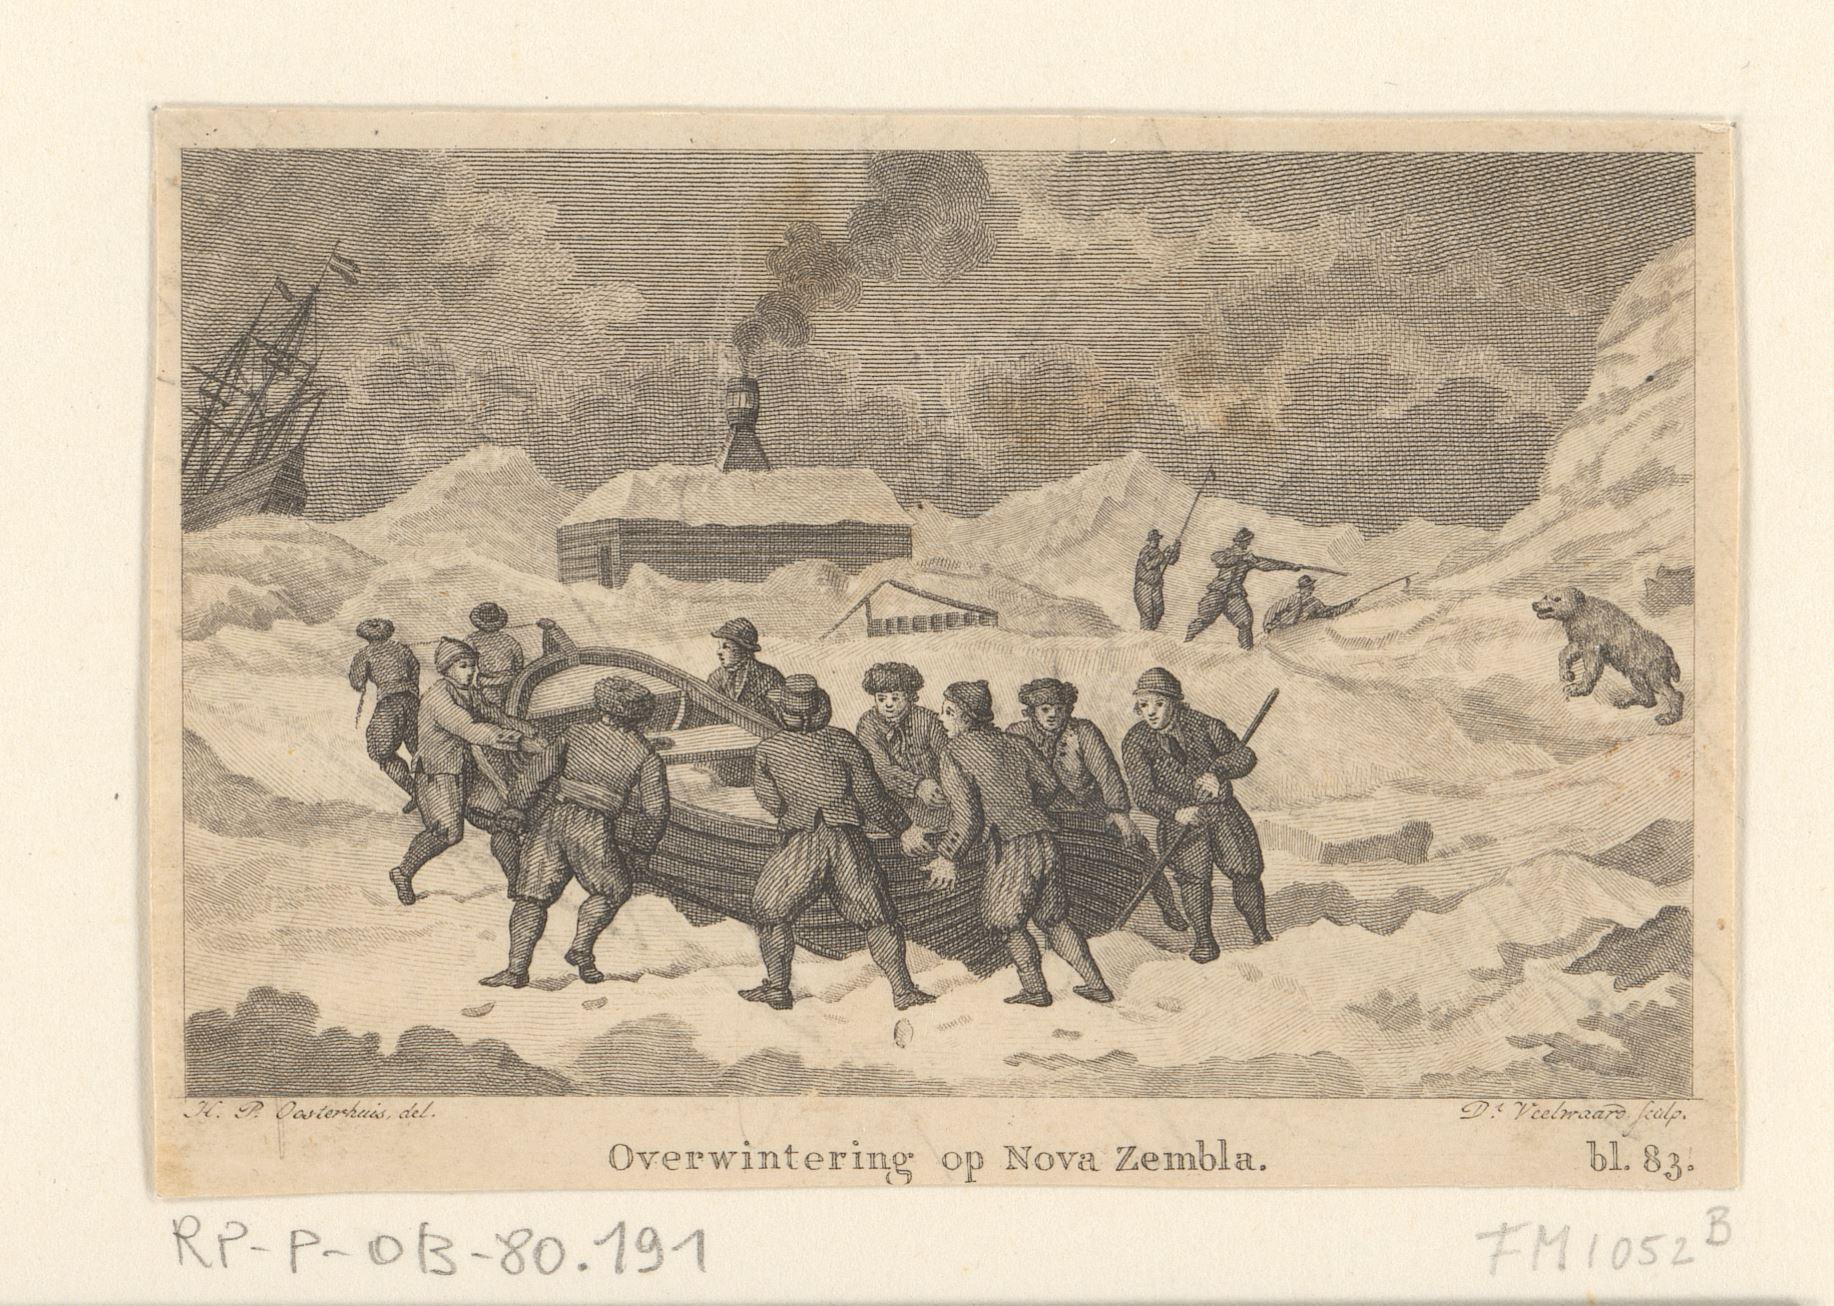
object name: print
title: Overwintering op Nova Zembla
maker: haatje pieters oosterhuis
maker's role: draughtsman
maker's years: 1784-1854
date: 1794-1854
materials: paper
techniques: etching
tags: willem barendsz., amsterdam, jacob van heemskerck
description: De overwintering op Nova Zembla, 1596-1597. De scheepsbemanning trekt een sloep op het ijs, op de achtergrond het Behouden Huys en de jacht op ijsberen.